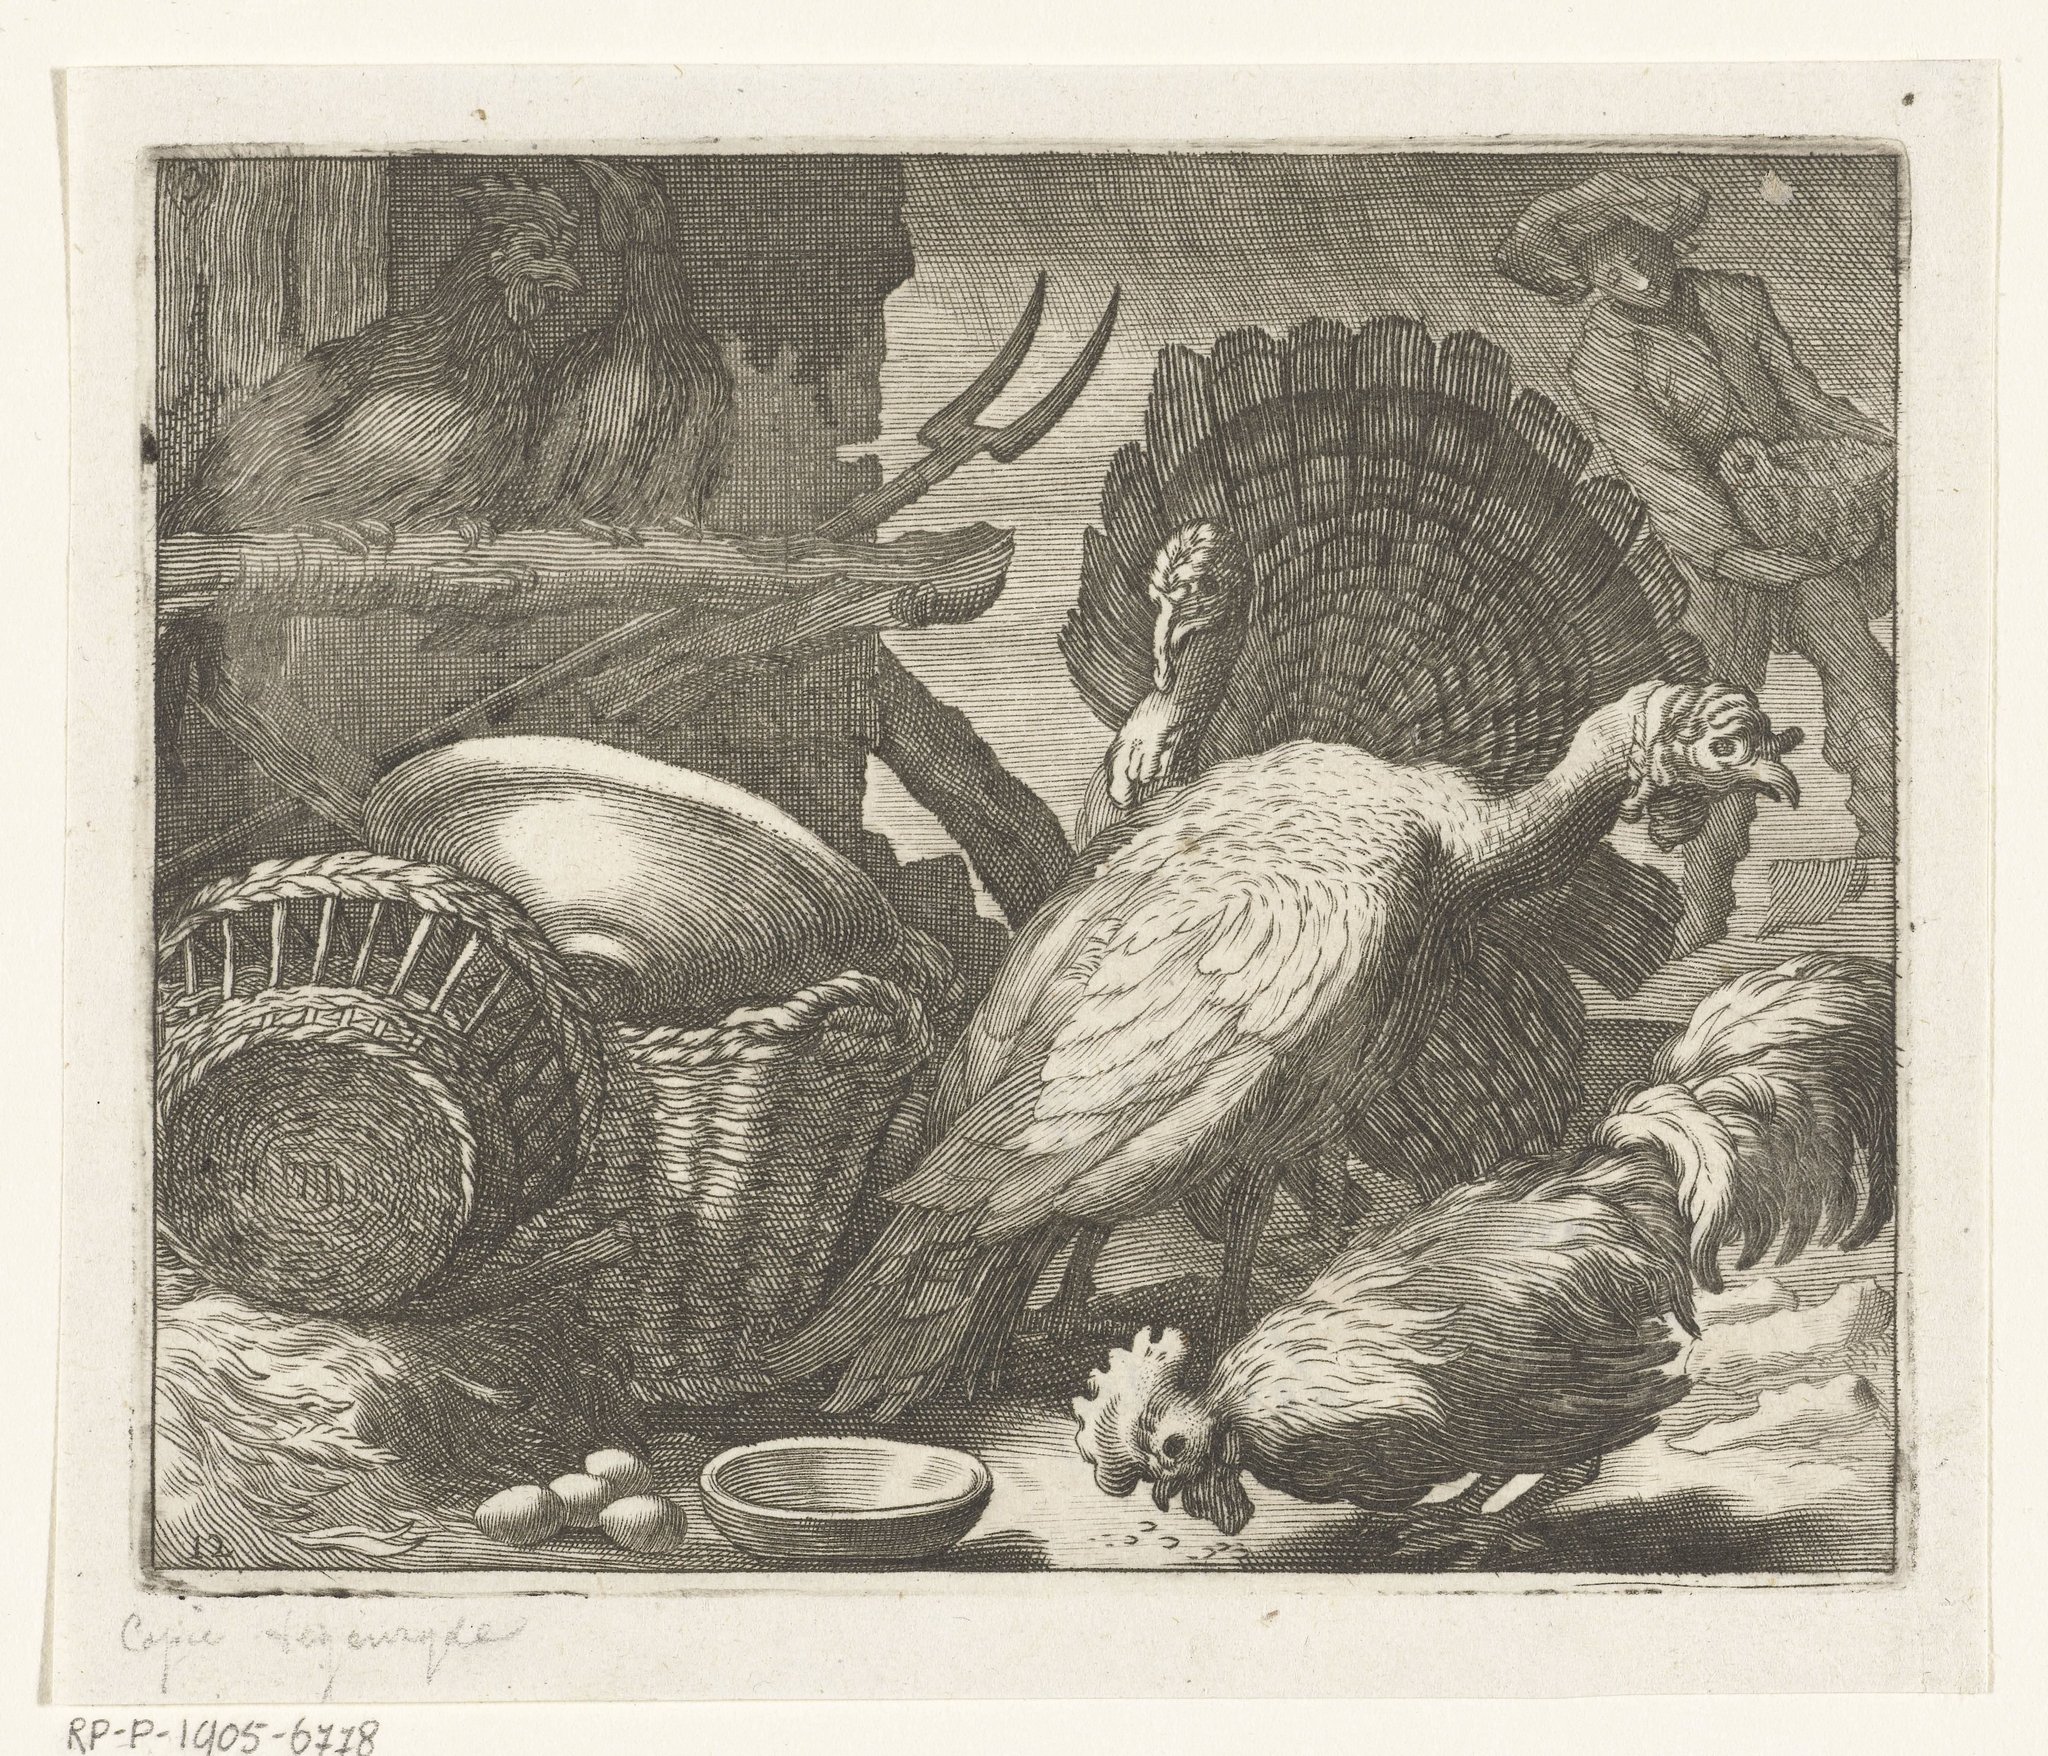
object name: print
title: Kippen en kalkoenen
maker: Anonymous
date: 1611-1661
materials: paper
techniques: engraving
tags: fowl (cock, hen, chicken, etc.), walker and runner birds: turkey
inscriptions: collector's mark: Lugt 2228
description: Kopie in spiegelbeeld naar prent uit serie met veertien prenten zogenaamde Pastoralen van B.A. Bolswert naar ontwerp van Abraham Bloemaert.